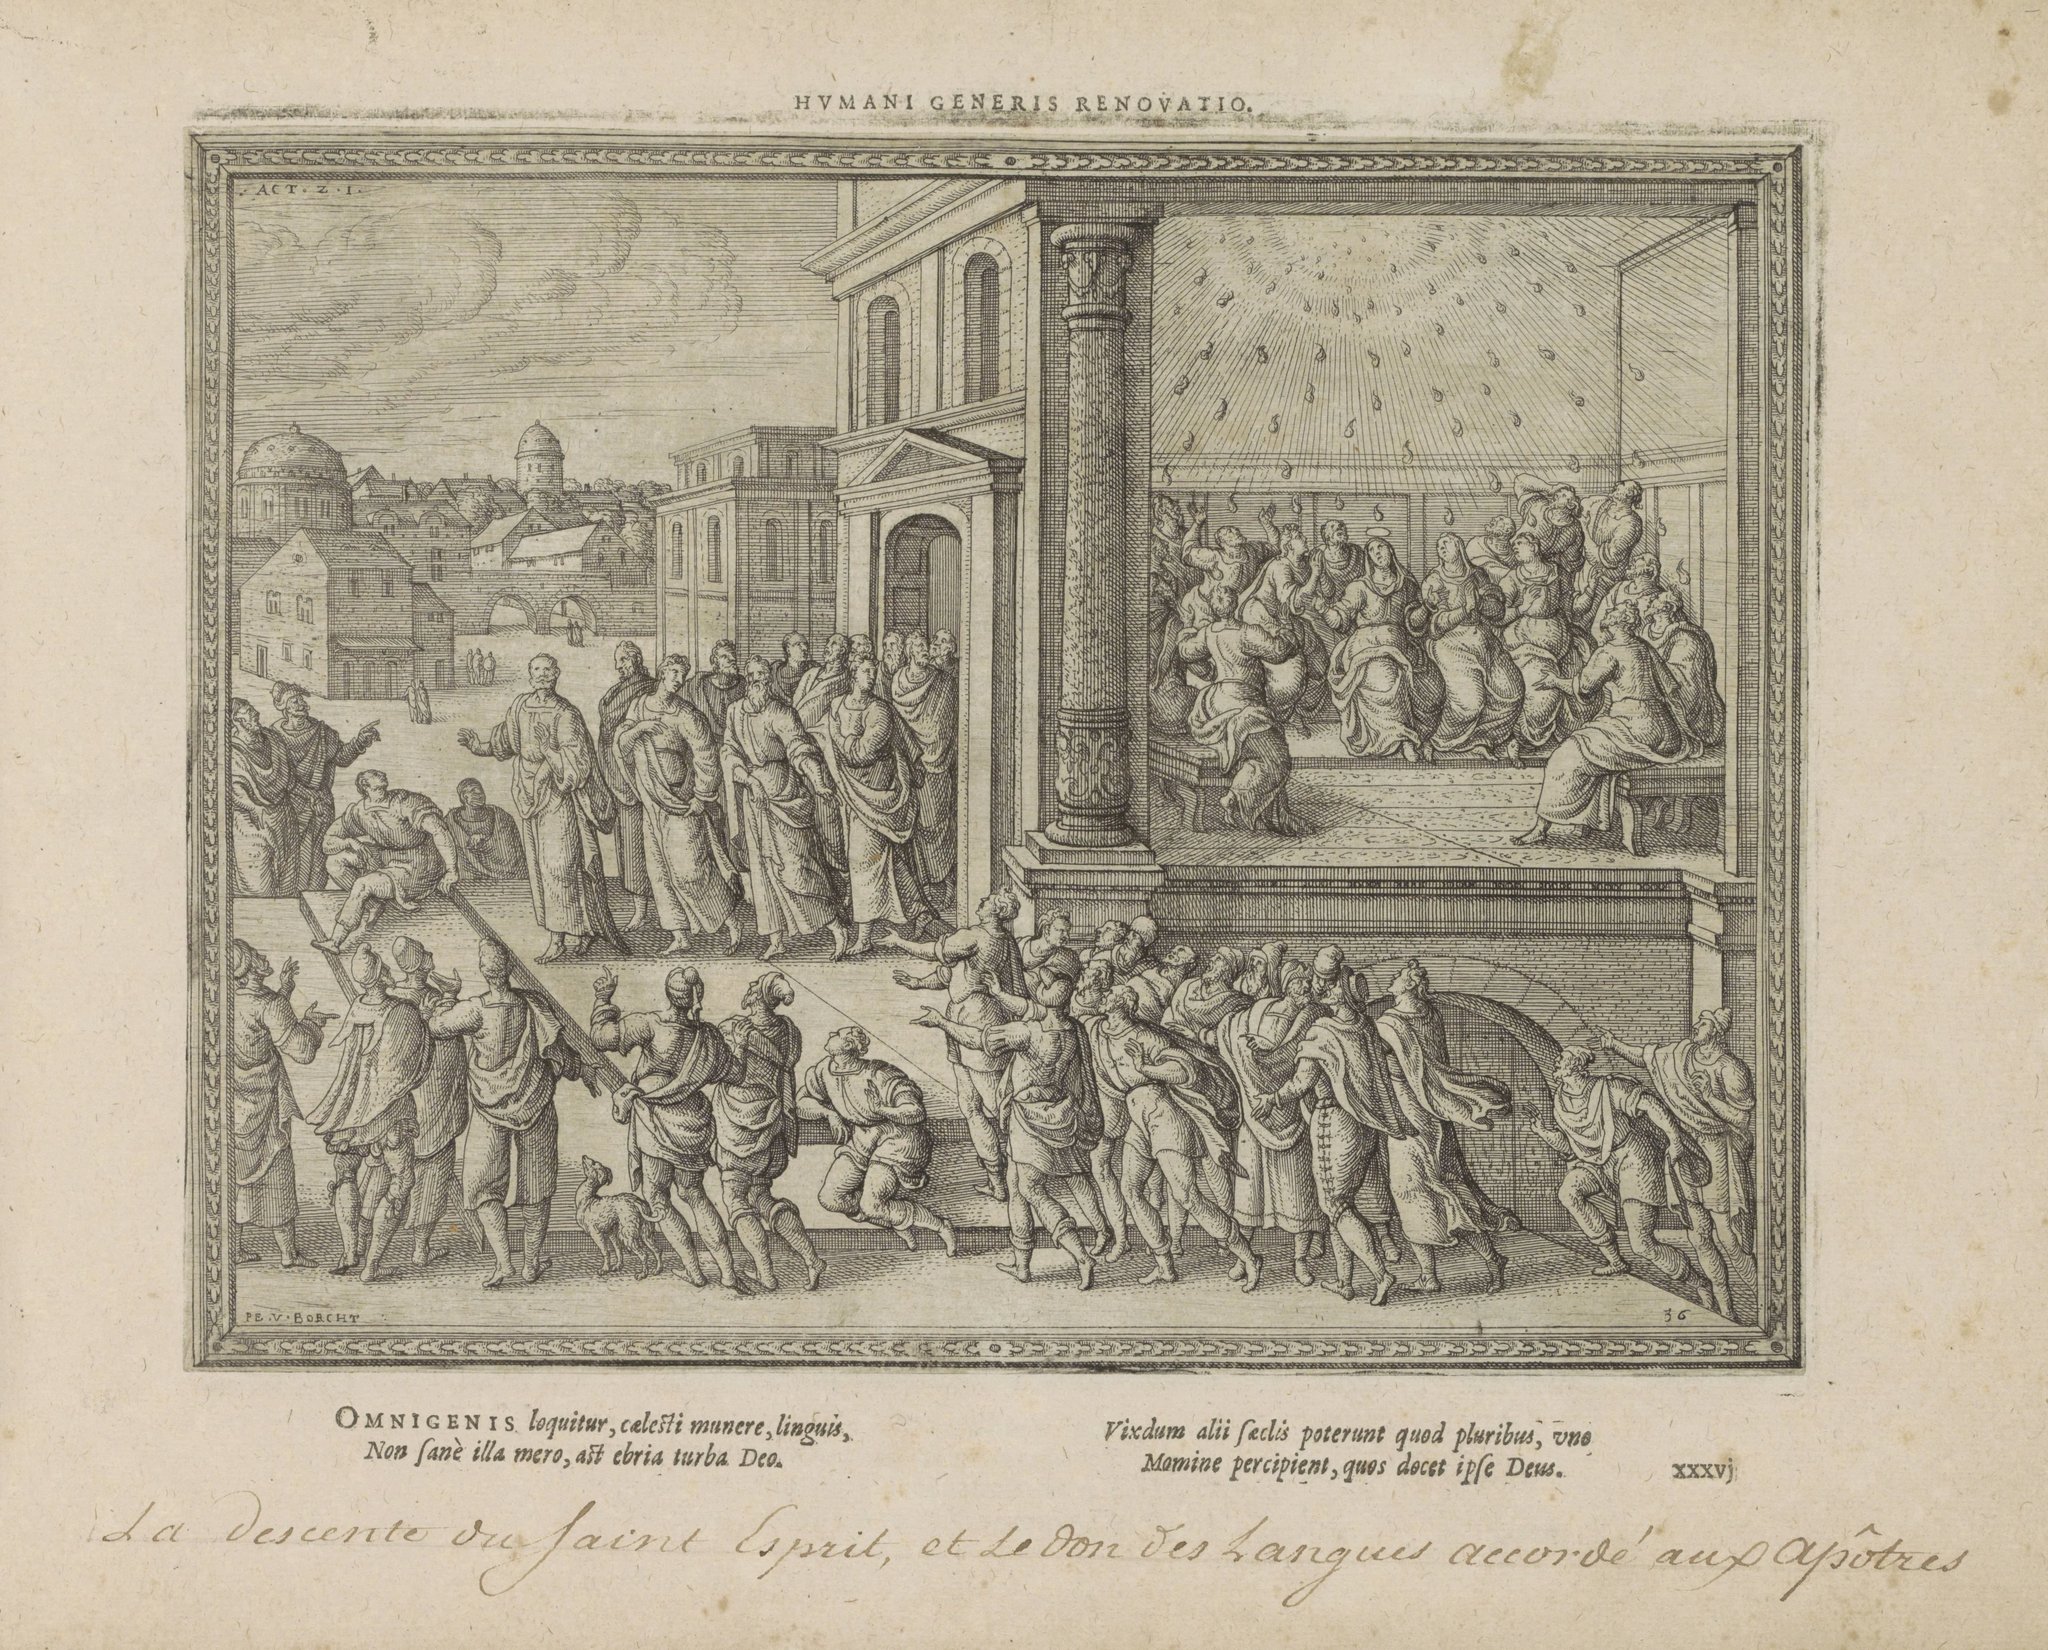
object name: print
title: Humani generis renovatio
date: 1582-1593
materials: paper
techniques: etching, letterpress printing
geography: antwerp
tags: the apostles take leave, and depart in all directions, pentecost: the holy ghost descends upon (mary and) the apostles, sometimes paul and/or representatives of the nations present (acts 2:1-4)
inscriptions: inscription: ‘La descente du saint esprit, et le don des langues accordé aux apotres’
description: In een zaal daalt de Heilige Geest neer op Maria, Maria Magdalena en de twaalf apostelen. De mensen in Jeruzalem drommen samen en zijn buiten zichzelf van verbazing, omdat zij de apostelen ieder in hun eigen taal horen spreken (Handelingen 2). Met een motto in het Latijn boven de voorstelling en een vierregelig onderschrift in het Latijn onder de prent. De prent maakt deel uit van een album.